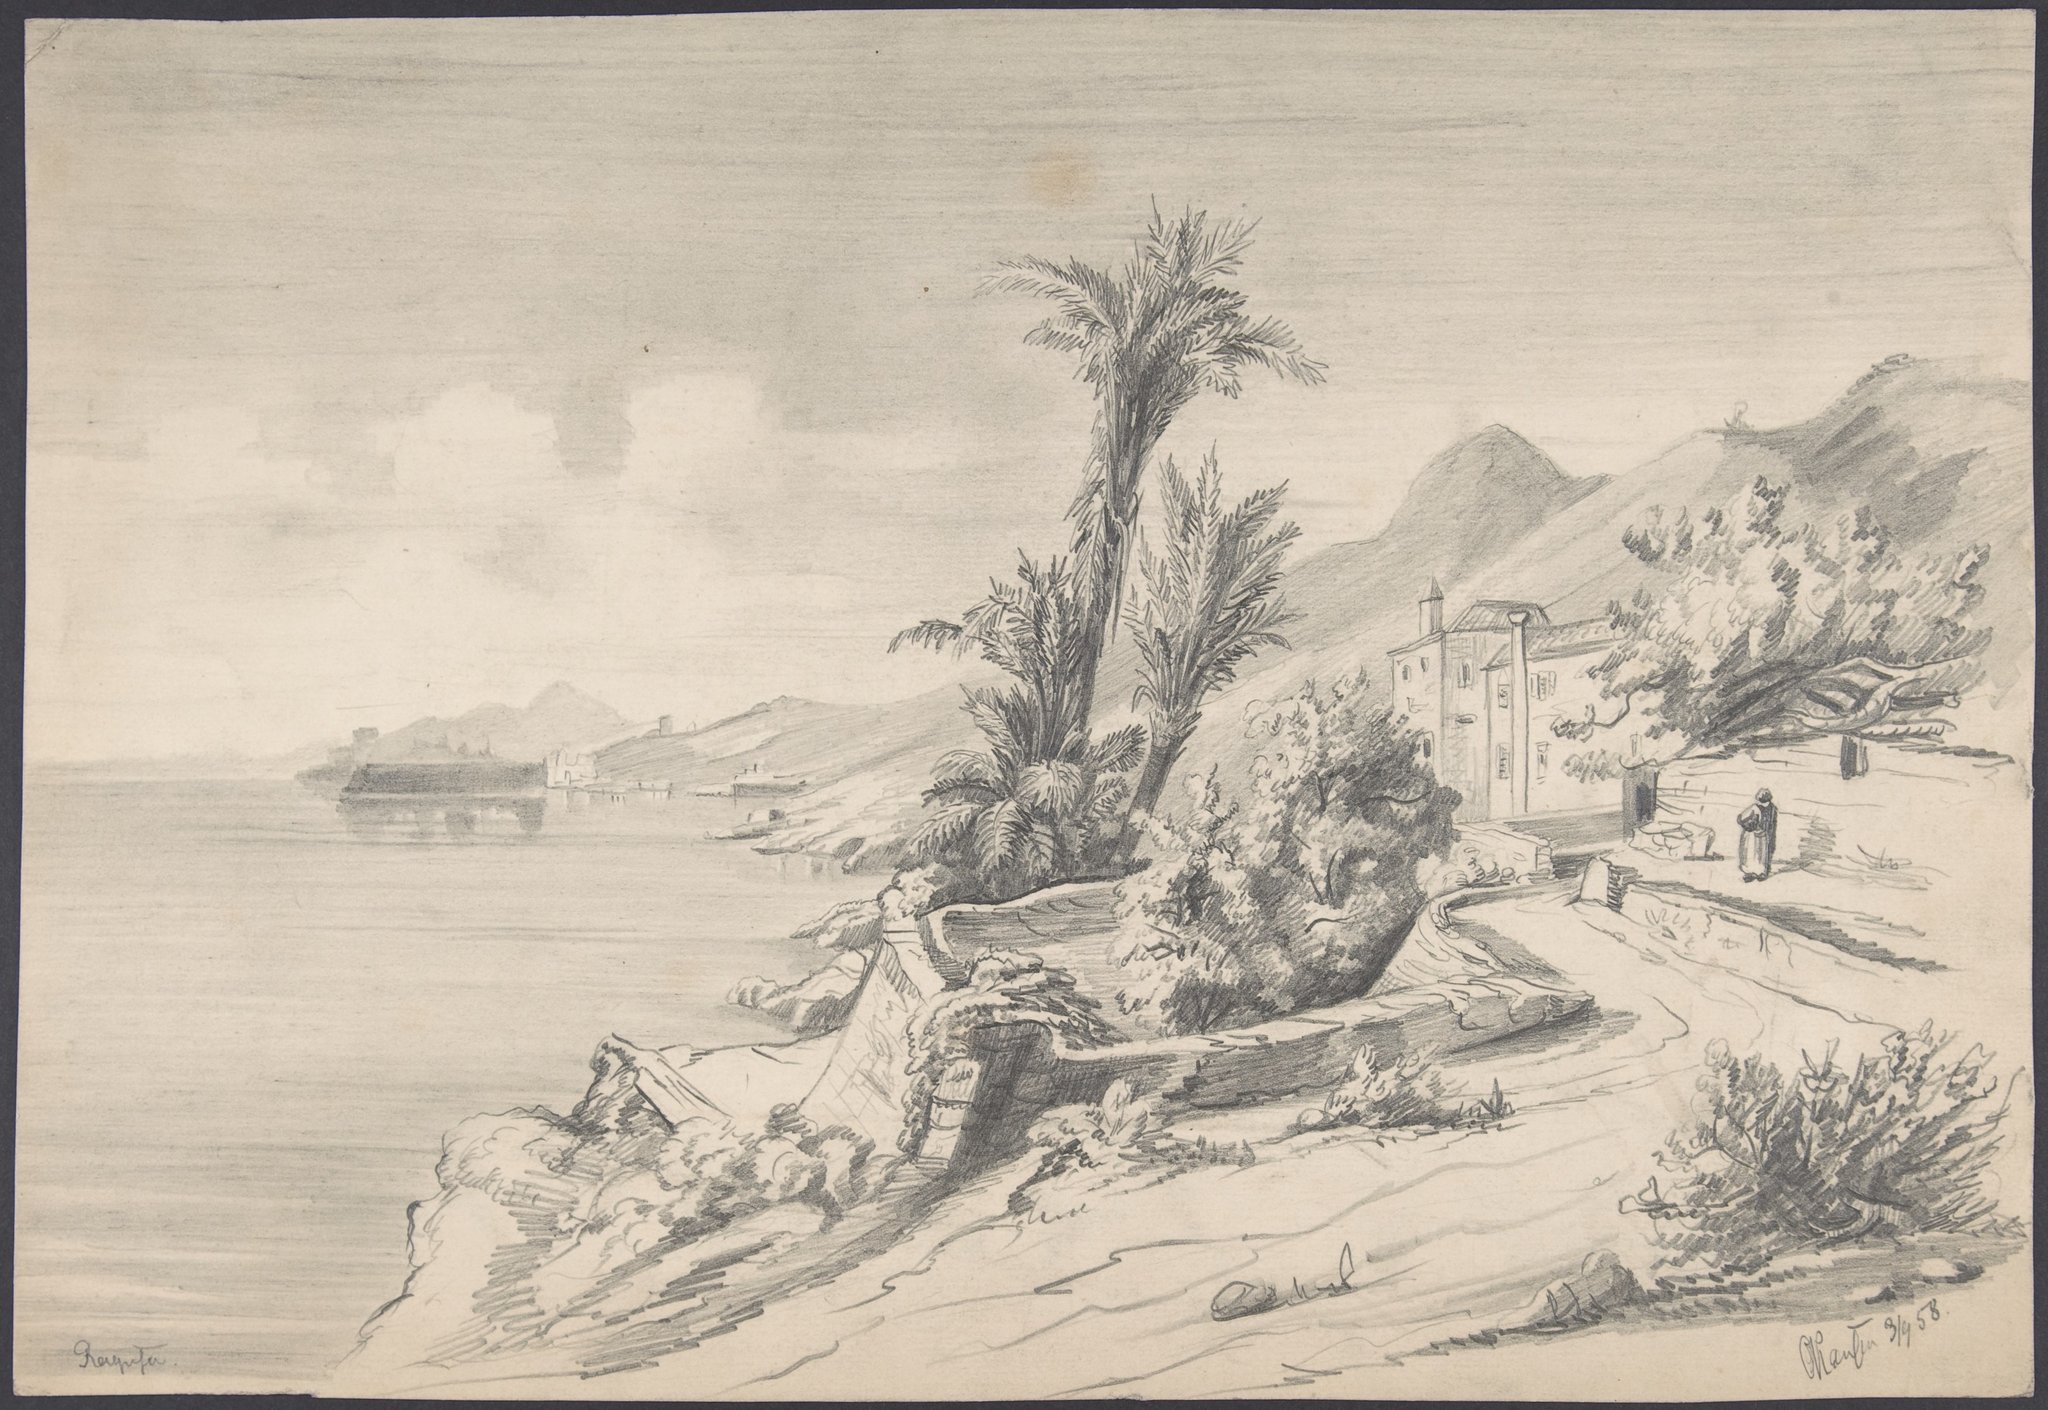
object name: drawing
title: Mediterranean landscape (recto); Mountains (verso)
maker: alexandre calame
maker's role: artist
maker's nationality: swiss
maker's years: 1810-1864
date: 1830-1864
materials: graphite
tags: mountains,landscapes